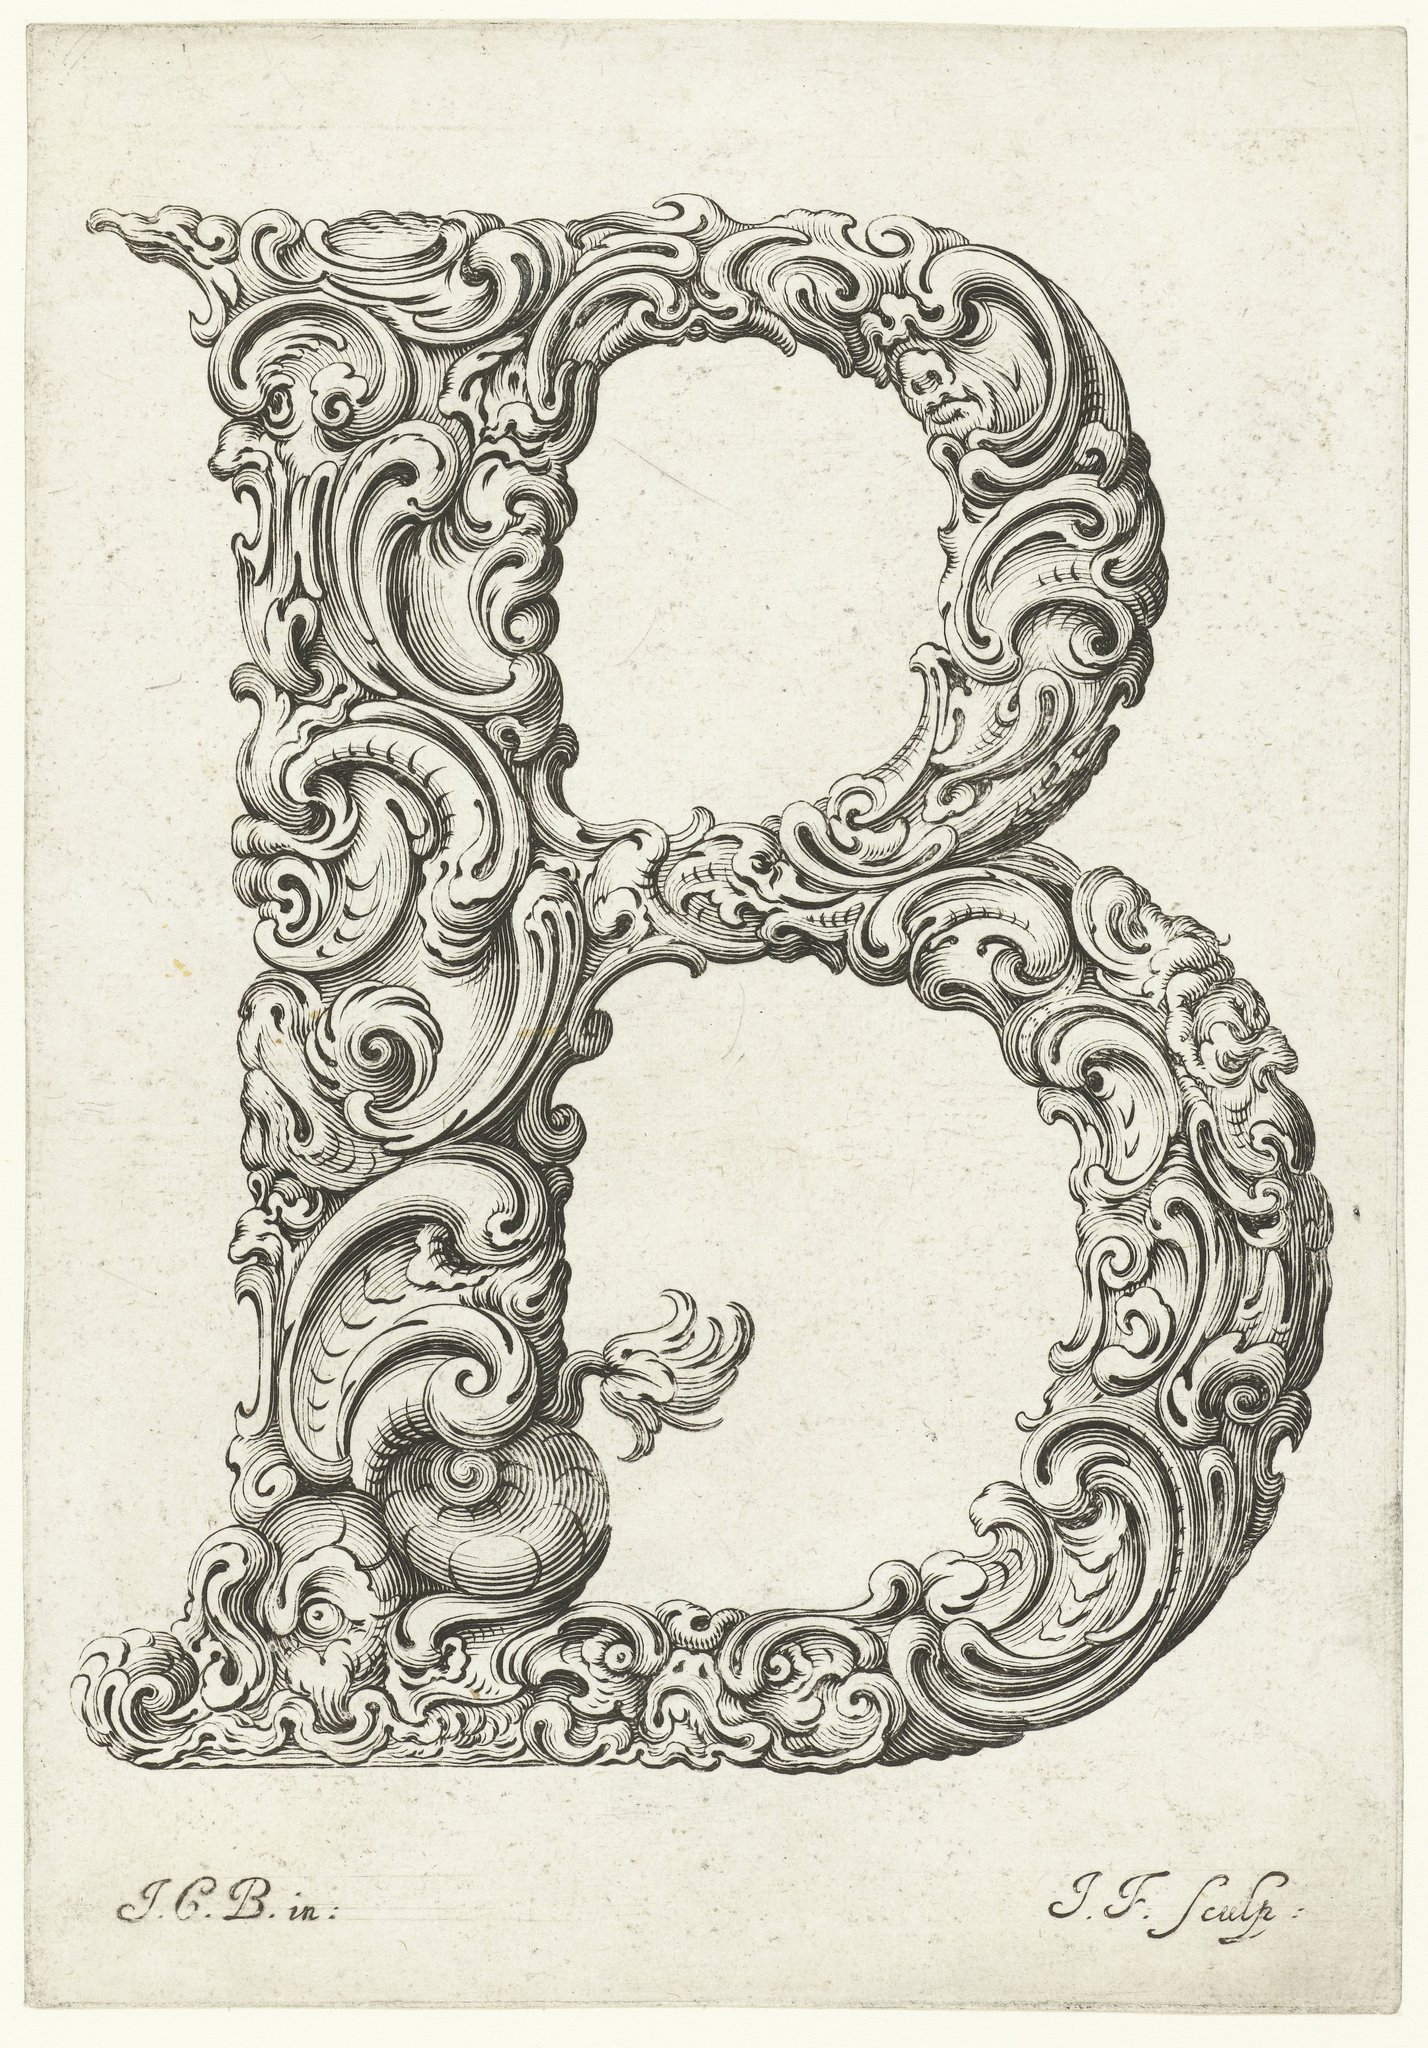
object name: print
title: Letter B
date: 1645-1650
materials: paper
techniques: engraving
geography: hamburg